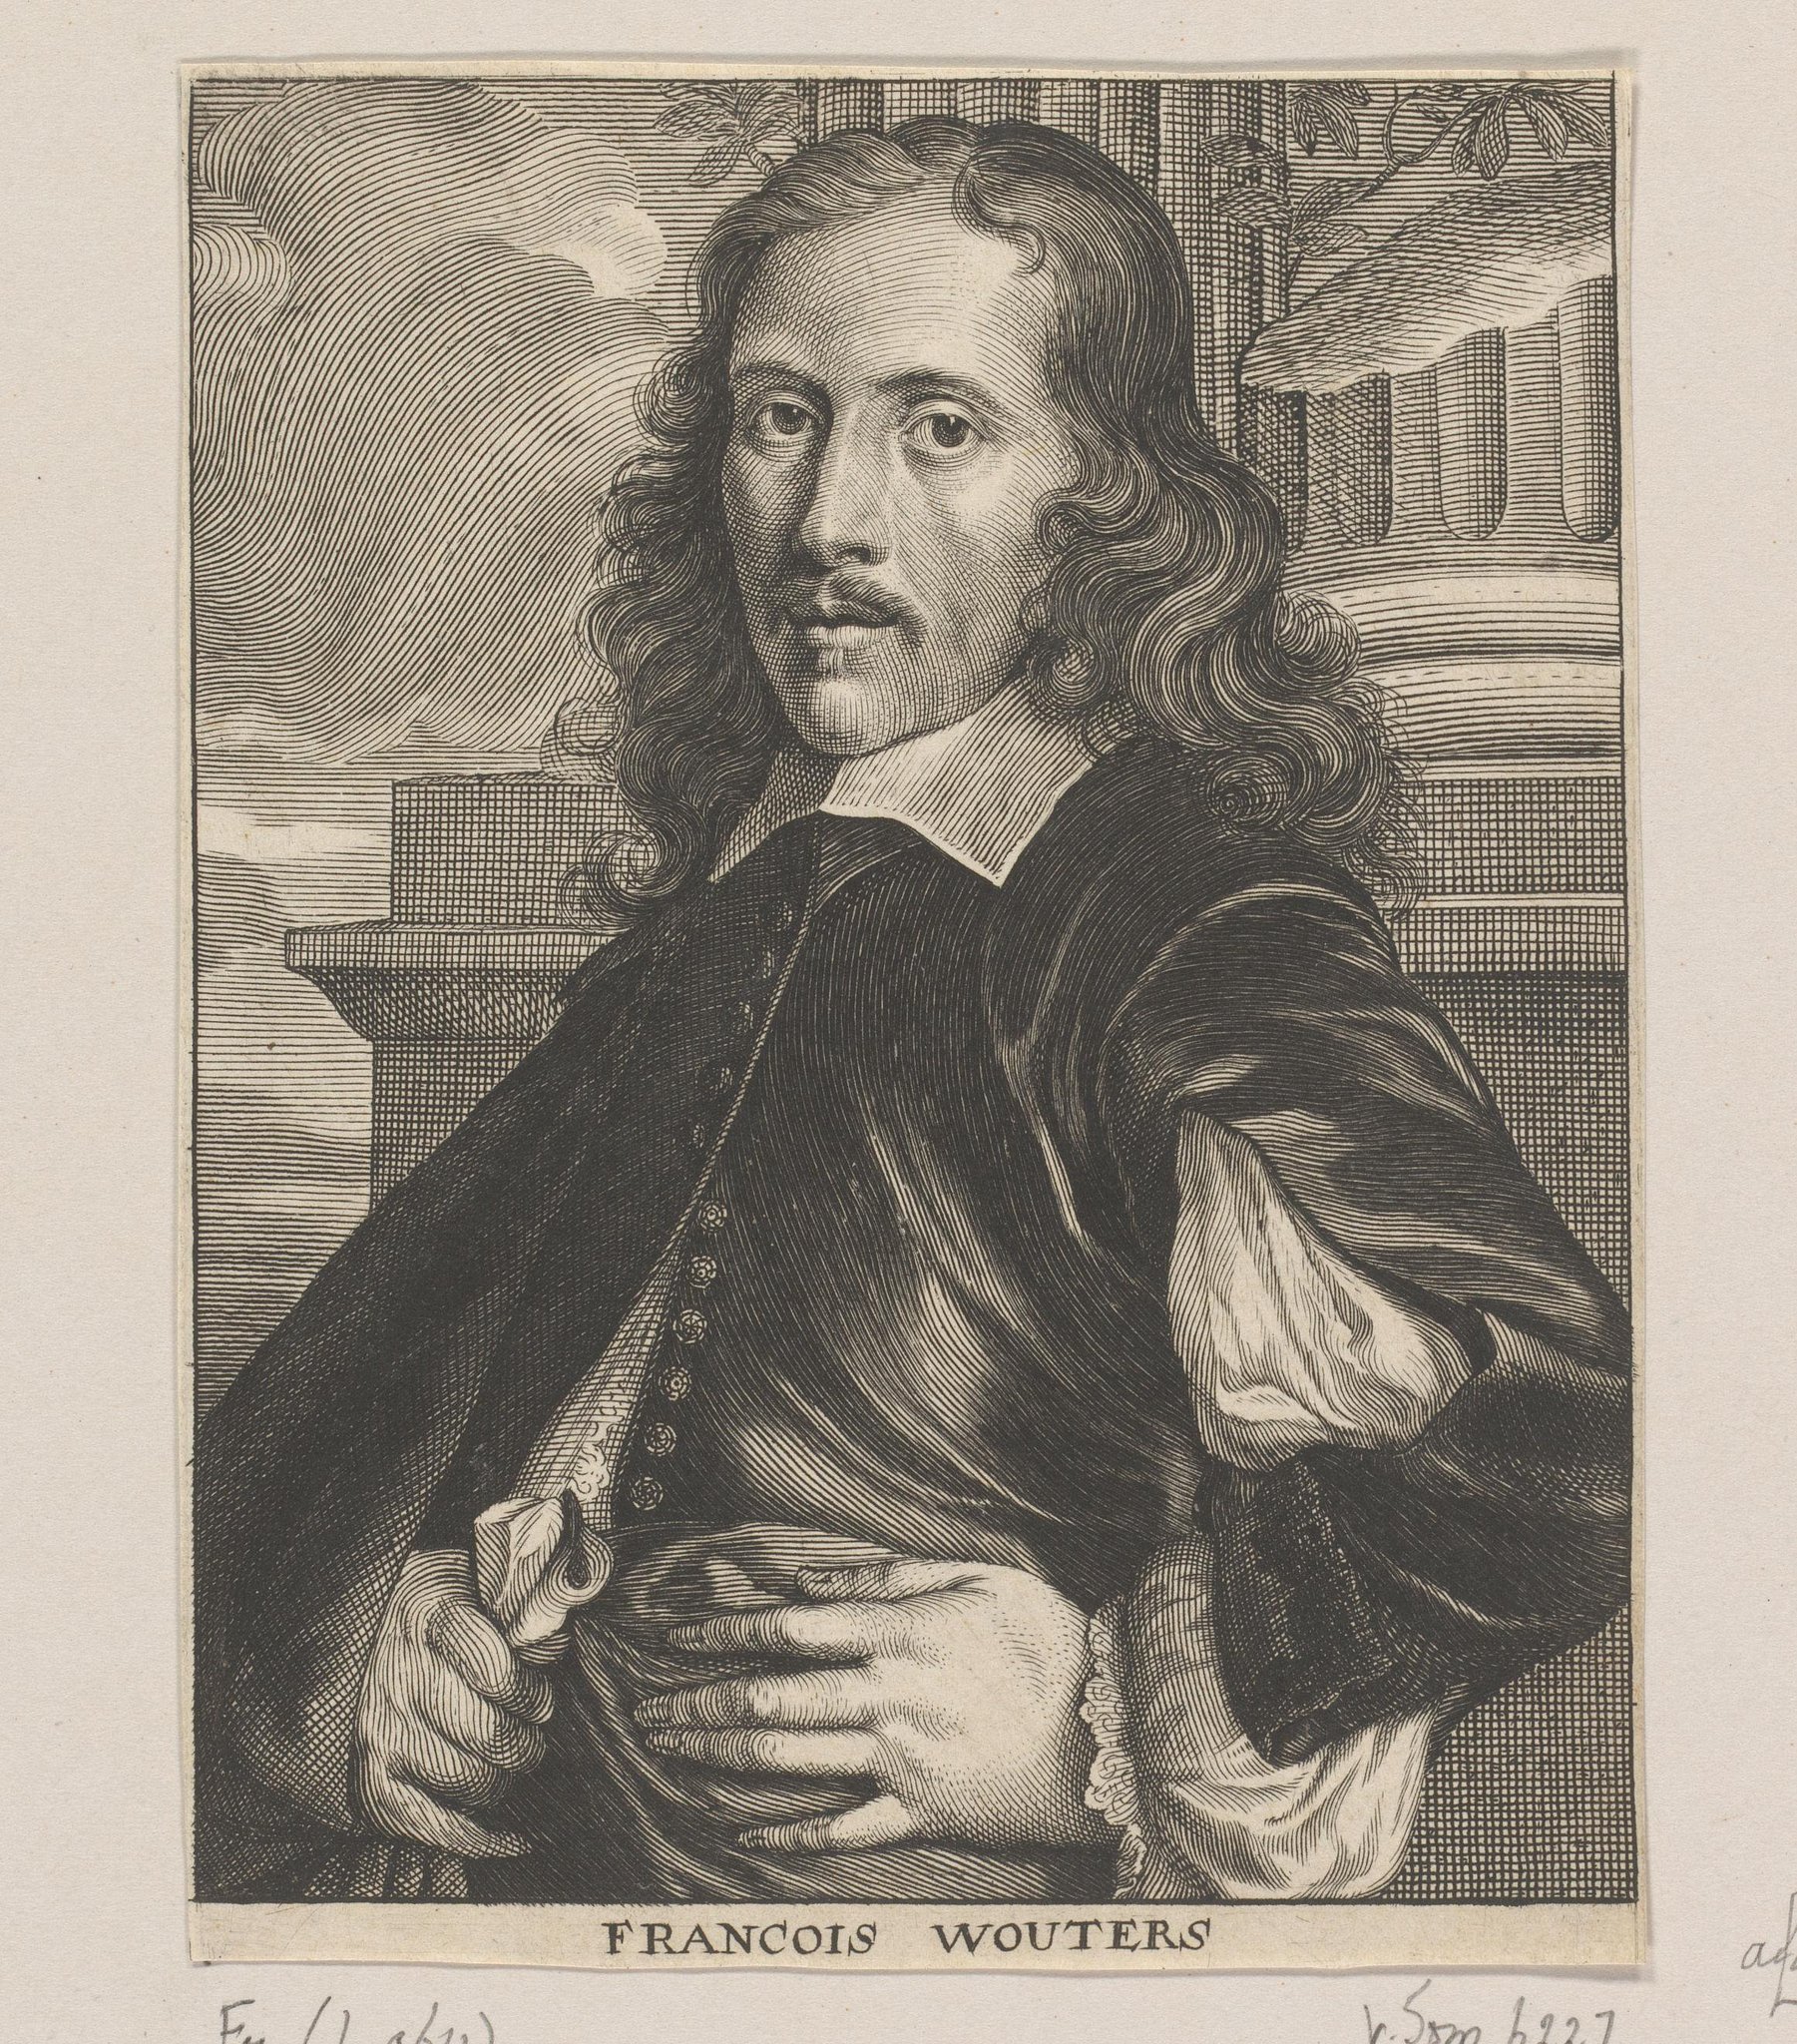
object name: print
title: Portret van Frans Wouters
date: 1649-1739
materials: paper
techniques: engraving, etching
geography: antwerp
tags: lierre, painter, frans wouters, historical persons, portrait, self-portrait of painter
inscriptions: inscription: ‘April=89’, collector's mark: Lugt 964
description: Prent gebruikt in: Bie, Cornelis De. Het gulden Cabinet vande edel vry schilder const, inhoudende den lof vande vermarste schilders, architecte, beldthowers ende plaetsnyders van dese eeuw. Antwerpen: Joannes Meyssens, 1662 [1661 foutief op titelpagina]. En mogelijk ook al in: Meyssens, Joannes. Image de divers hommes desprit sublime qui par leur art et science deburovent vivre eternellement et des quels la louange et renommée faict estonner le monde. 2 dln. Antwerpen: Joannes Meyssens, 1649. Tweede bekende staat (genummerd 54) gebruikt in: Resta, Sebastiano. The true effigies of the most eminent painters and other famous artists that have flourished in Europe. Londen, 1694. Derde bekende staat (genummerd 35) gebruikt in: The Portraits of the Most Eminent Painters, and other Famous Artists (...). Londen: Olive Payne, 1739.